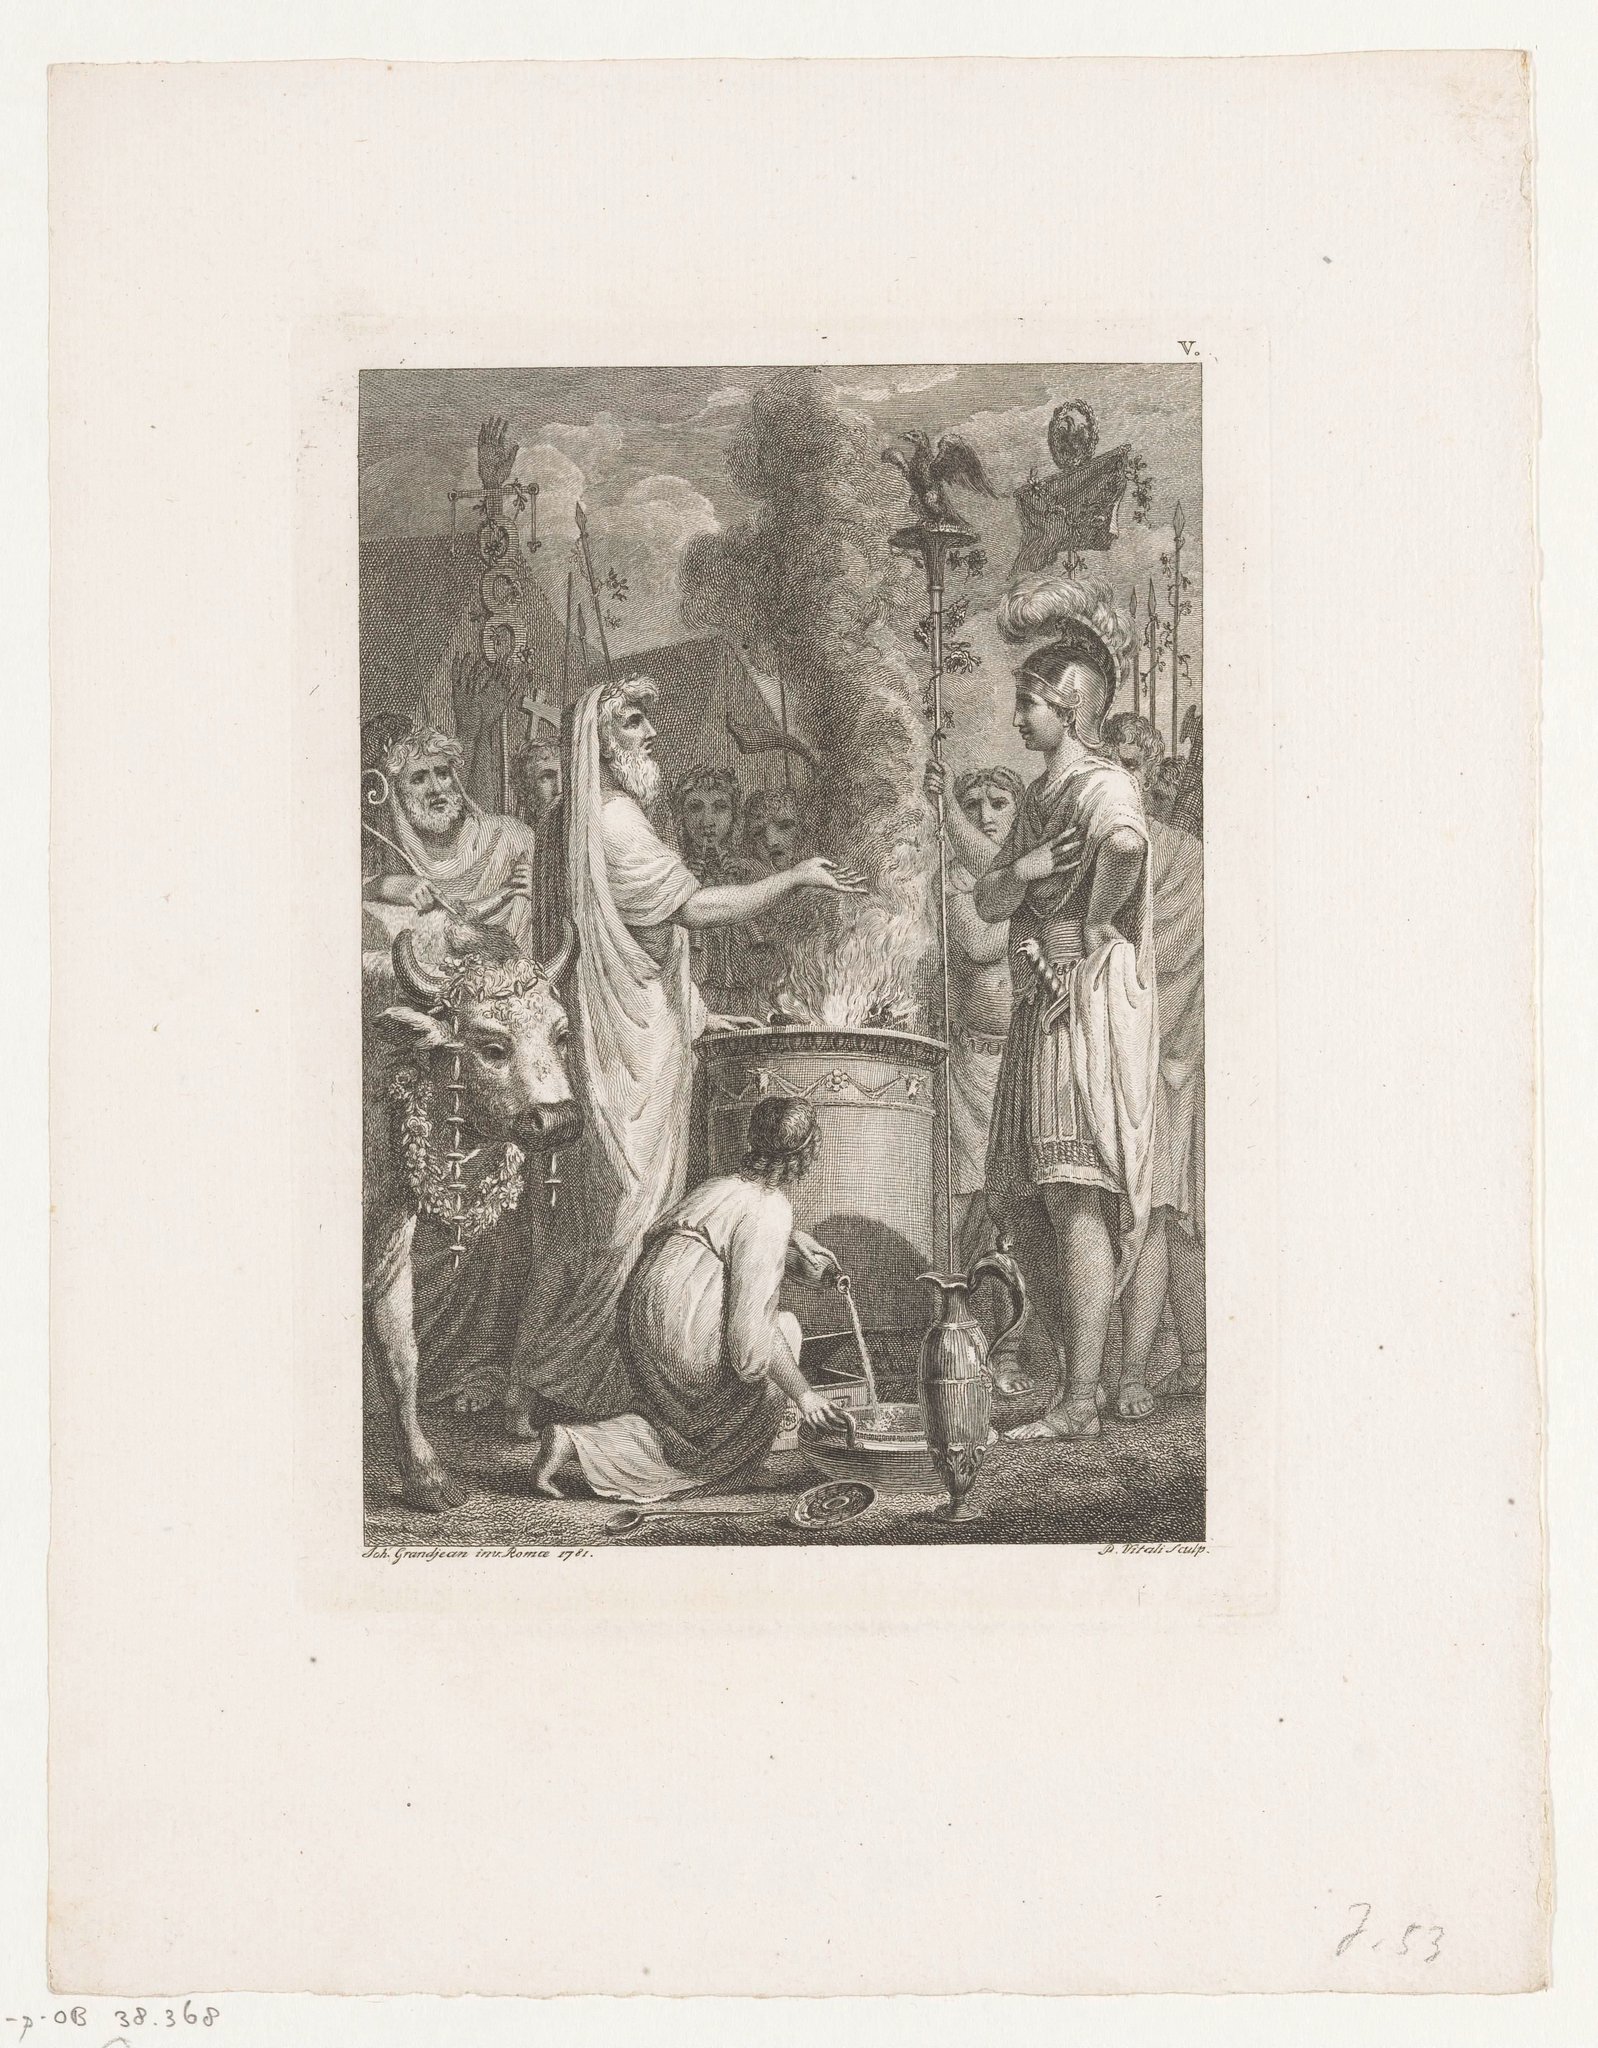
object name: print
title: Germanicus bij een offer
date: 1781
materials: paper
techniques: engraving, etching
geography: rome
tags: (story of) germanicus, sacrifice ~ roman religion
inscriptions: collector's mark: Lugt 2228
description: Prent gebruikt voor de publicatie: Winter, Lucretia Wilhelmina van. Germanicus: In zestien boeken. Amsterdam: P. Meijer, 1779.